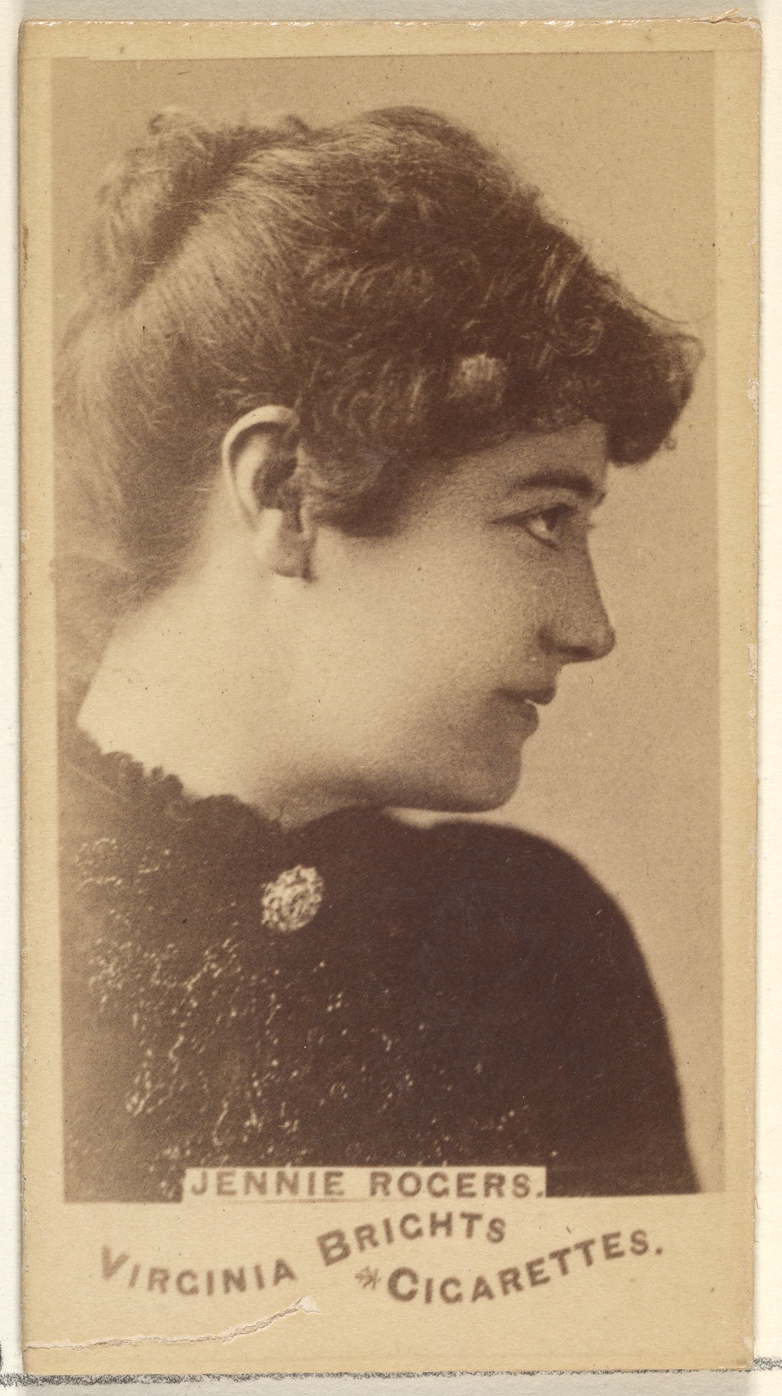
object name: photograph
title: Jennie Rogers, from the Actors and Actresses series (N45, Type 1) for Virginia Brights Cigarettes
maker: allen & ginter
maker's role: publisher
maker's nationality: american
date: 1888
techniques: albumen silver print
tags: portraits,women